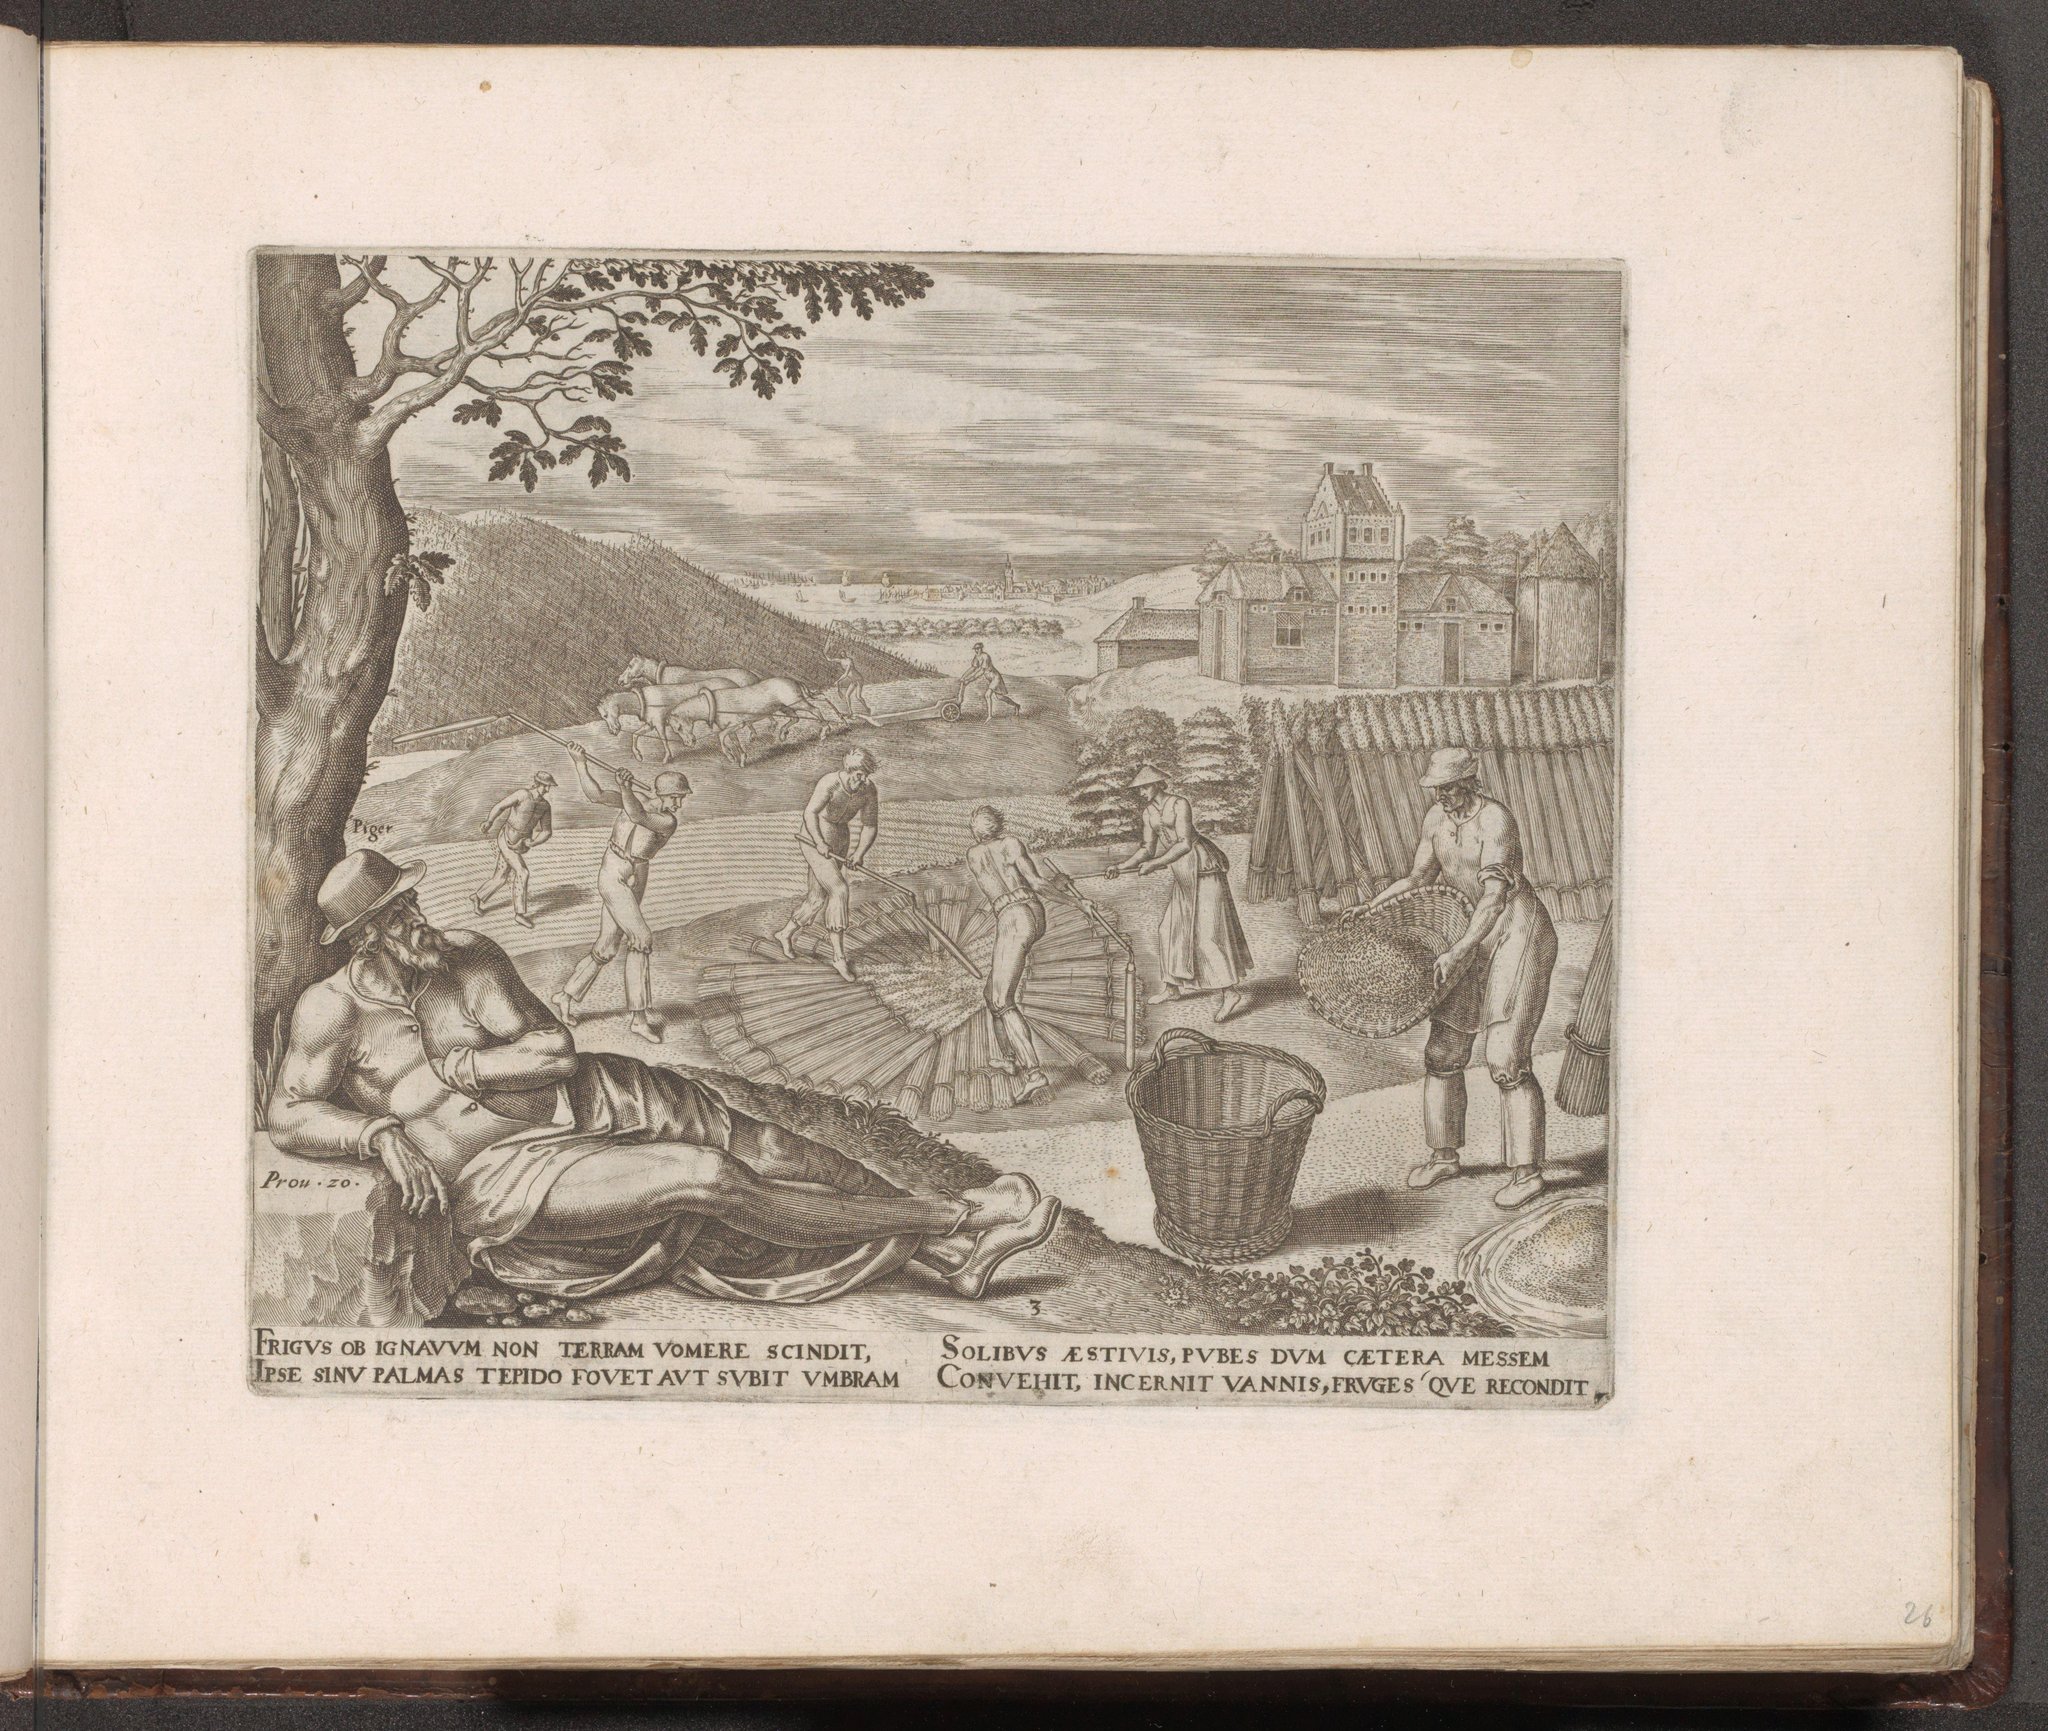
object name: print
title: Thesaurus sacrarum historiaru[m] veteris testame[n]ti, elega[n]tissimis imaginibus expressu[m] excelle[n]tissimoru[m] in hac arte viroru[m] opera: nu[n]c primu[m] in luce[m] editus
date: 1563-1567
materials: paper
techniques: engraving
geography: haarlem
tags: threshing, rest during harvest (eating, dancing, making love, etc.)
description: In een heuvelachtig landschap zijn boeren met de graanoogst bezig. Enkele mannen dorsen het graan. Op de achtergrond bewerken twee mannen een akker met een ploeg en zaait een man nieuw koren in. De luiaard ligt onder een boom en slaapt. Naar de Bijbeltekst in Spr. 20:4. Onder de voorstelling een verklarende tekst in het Latijn. Prent maakt deel uit van een album.